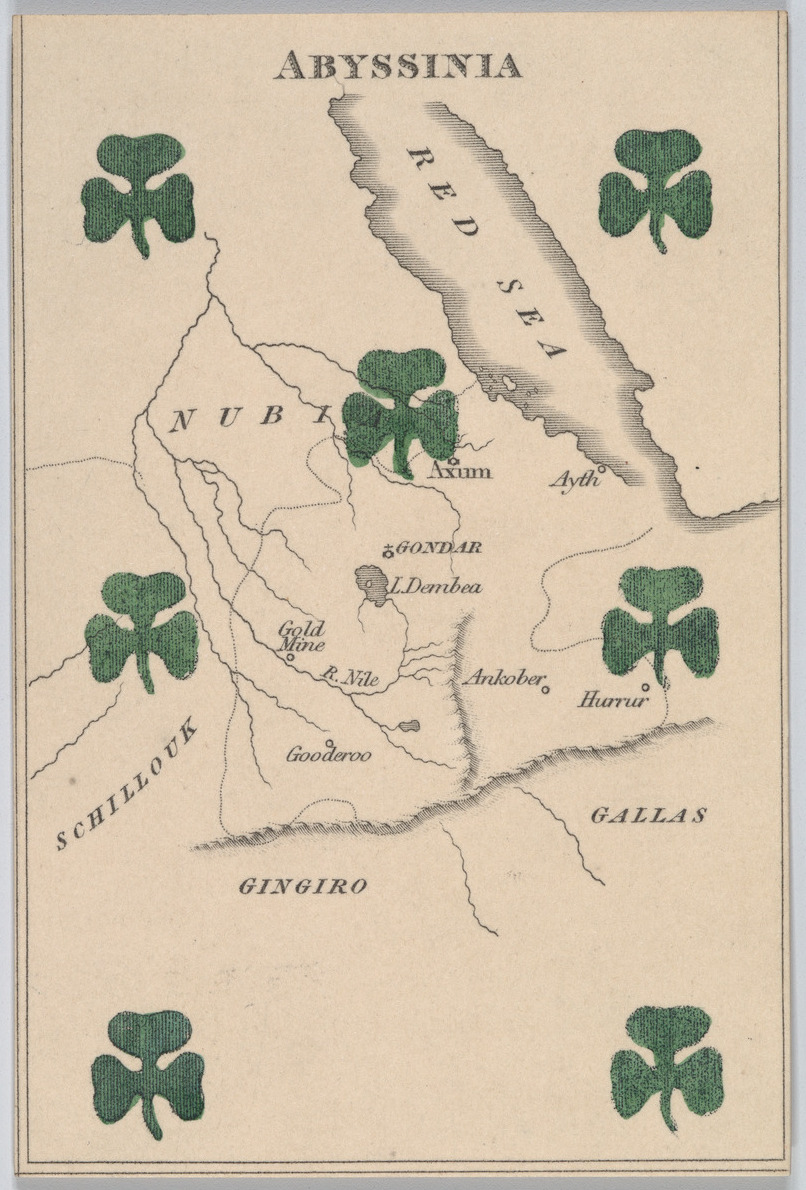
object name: print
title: Abyssinia, from "Court Game of Geography"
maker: william and henry rock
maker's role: publisher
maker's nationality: british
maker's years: 1821-1884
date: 1838-1855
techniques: engraving, hand coloring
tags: playing cards,maps